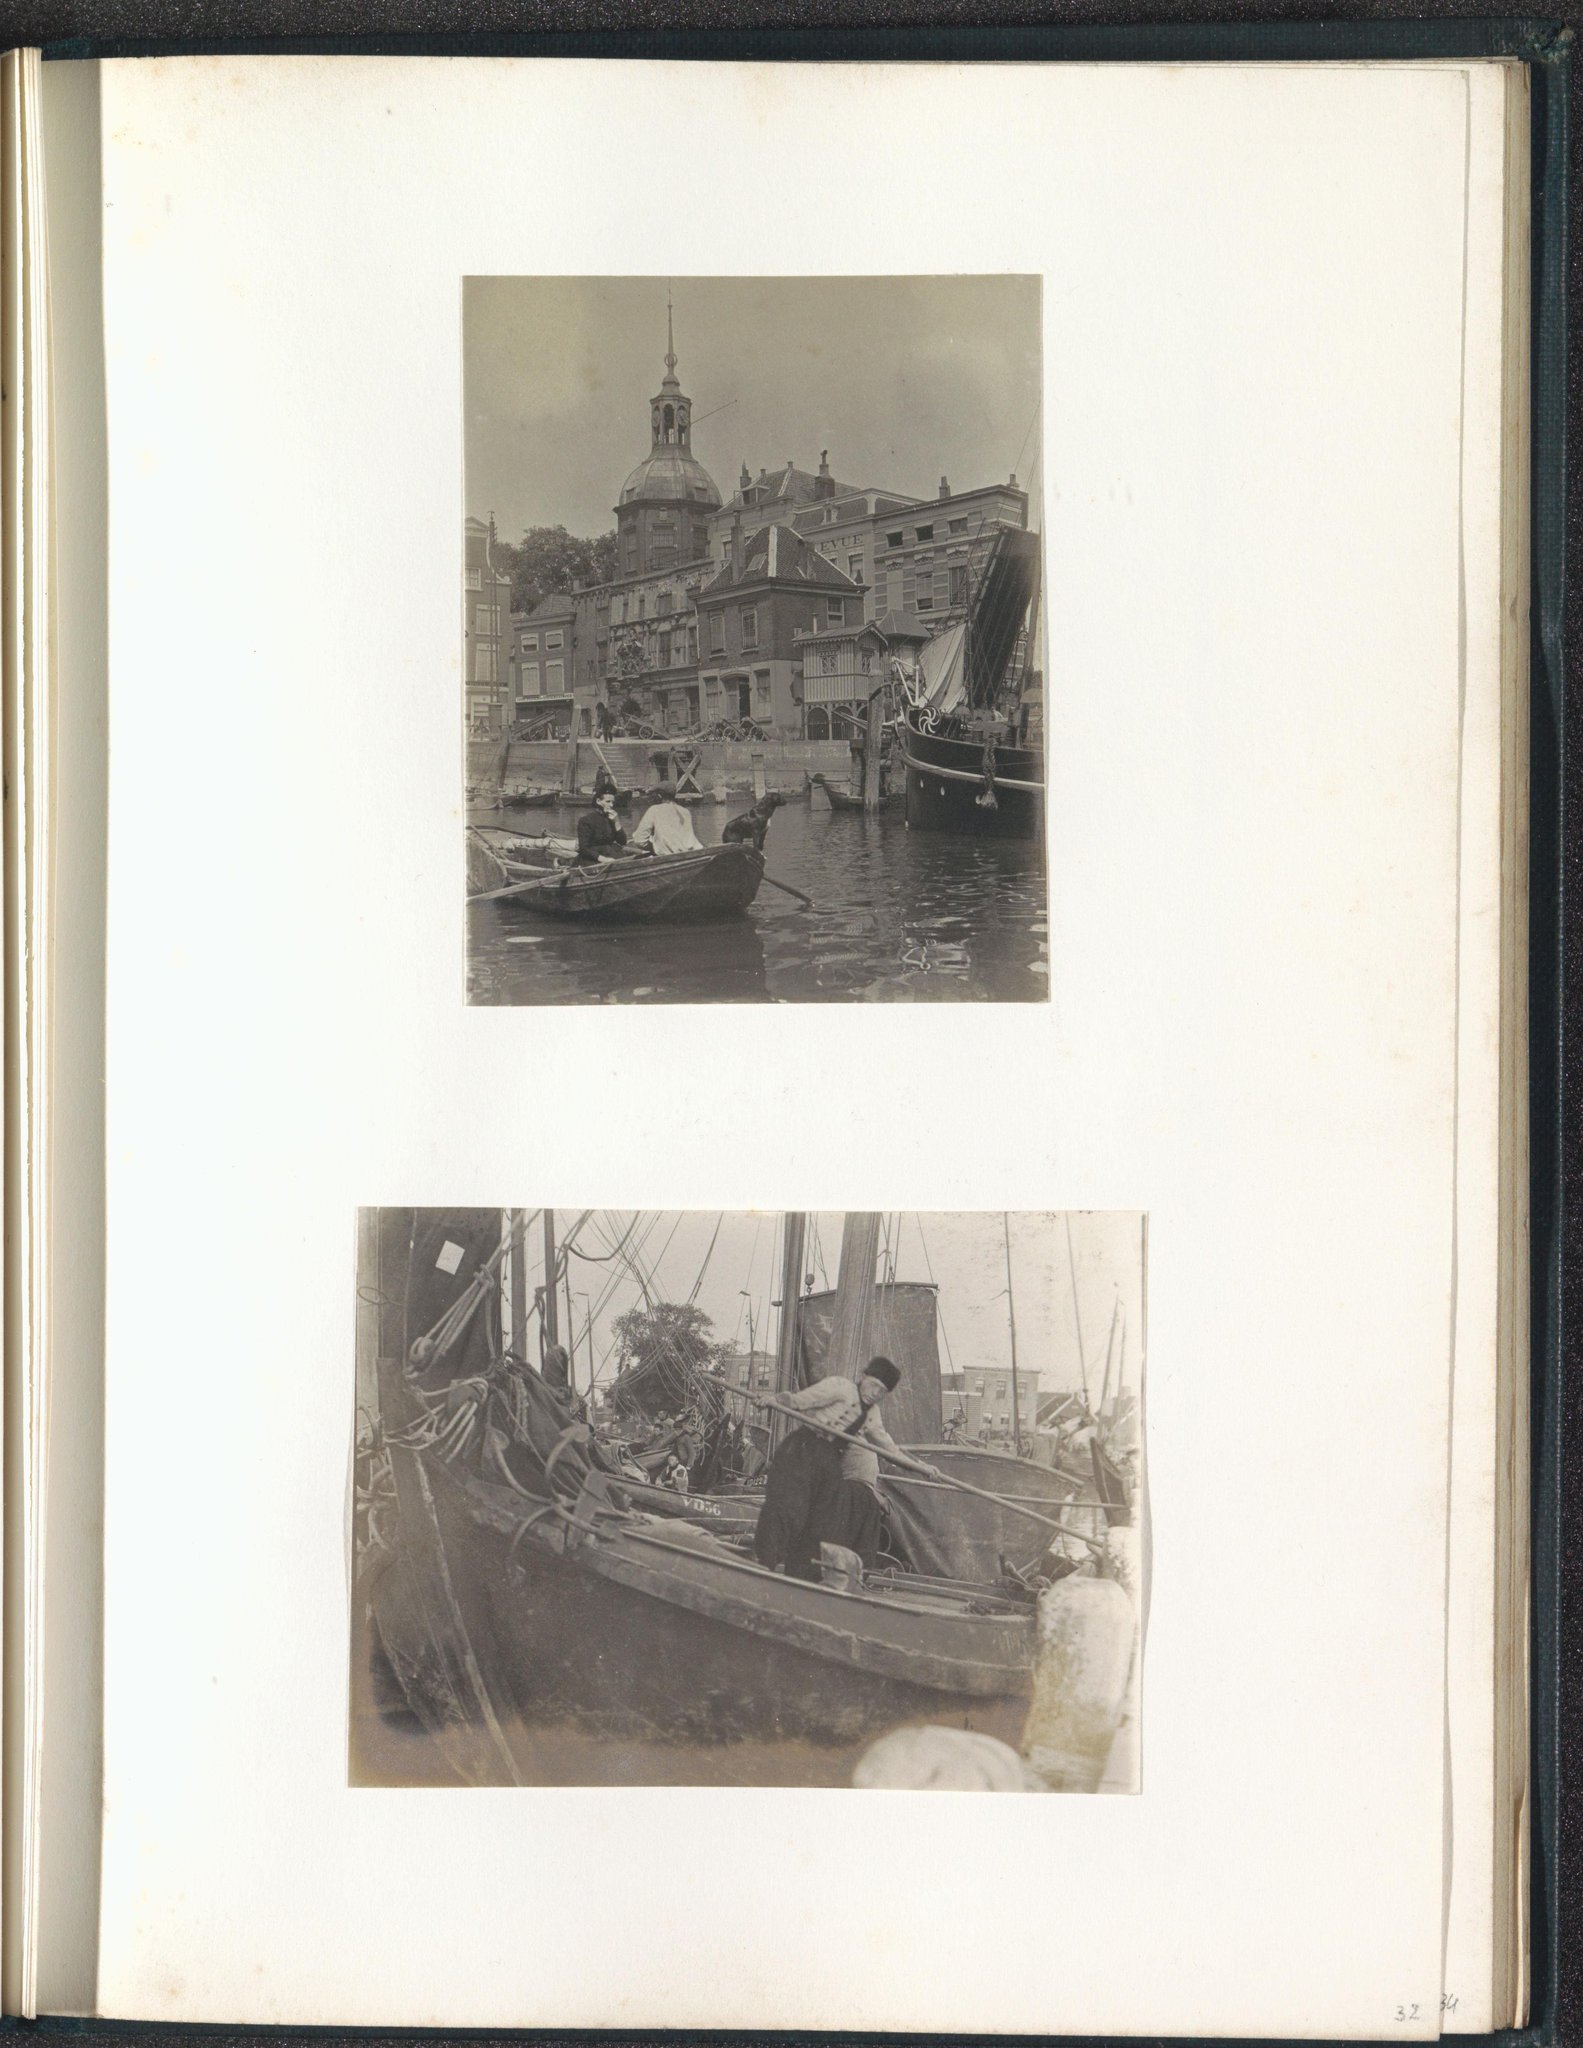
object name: photograph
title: Man in Volendamse klederdracht staand in een zeilschip met een stok in de hand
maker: george hidderley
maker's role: fotograaf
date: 1900-1910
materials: paper, photographic support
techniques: gelatin silver print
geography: volendam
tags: sailing-ship, sailing-boat, folk costume, regional costume (+ men's clothes), fisherman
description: Onderdeel van fotoalbum met opnames van Volendam, Dordrecht, Gorinchem en Woudrichem.